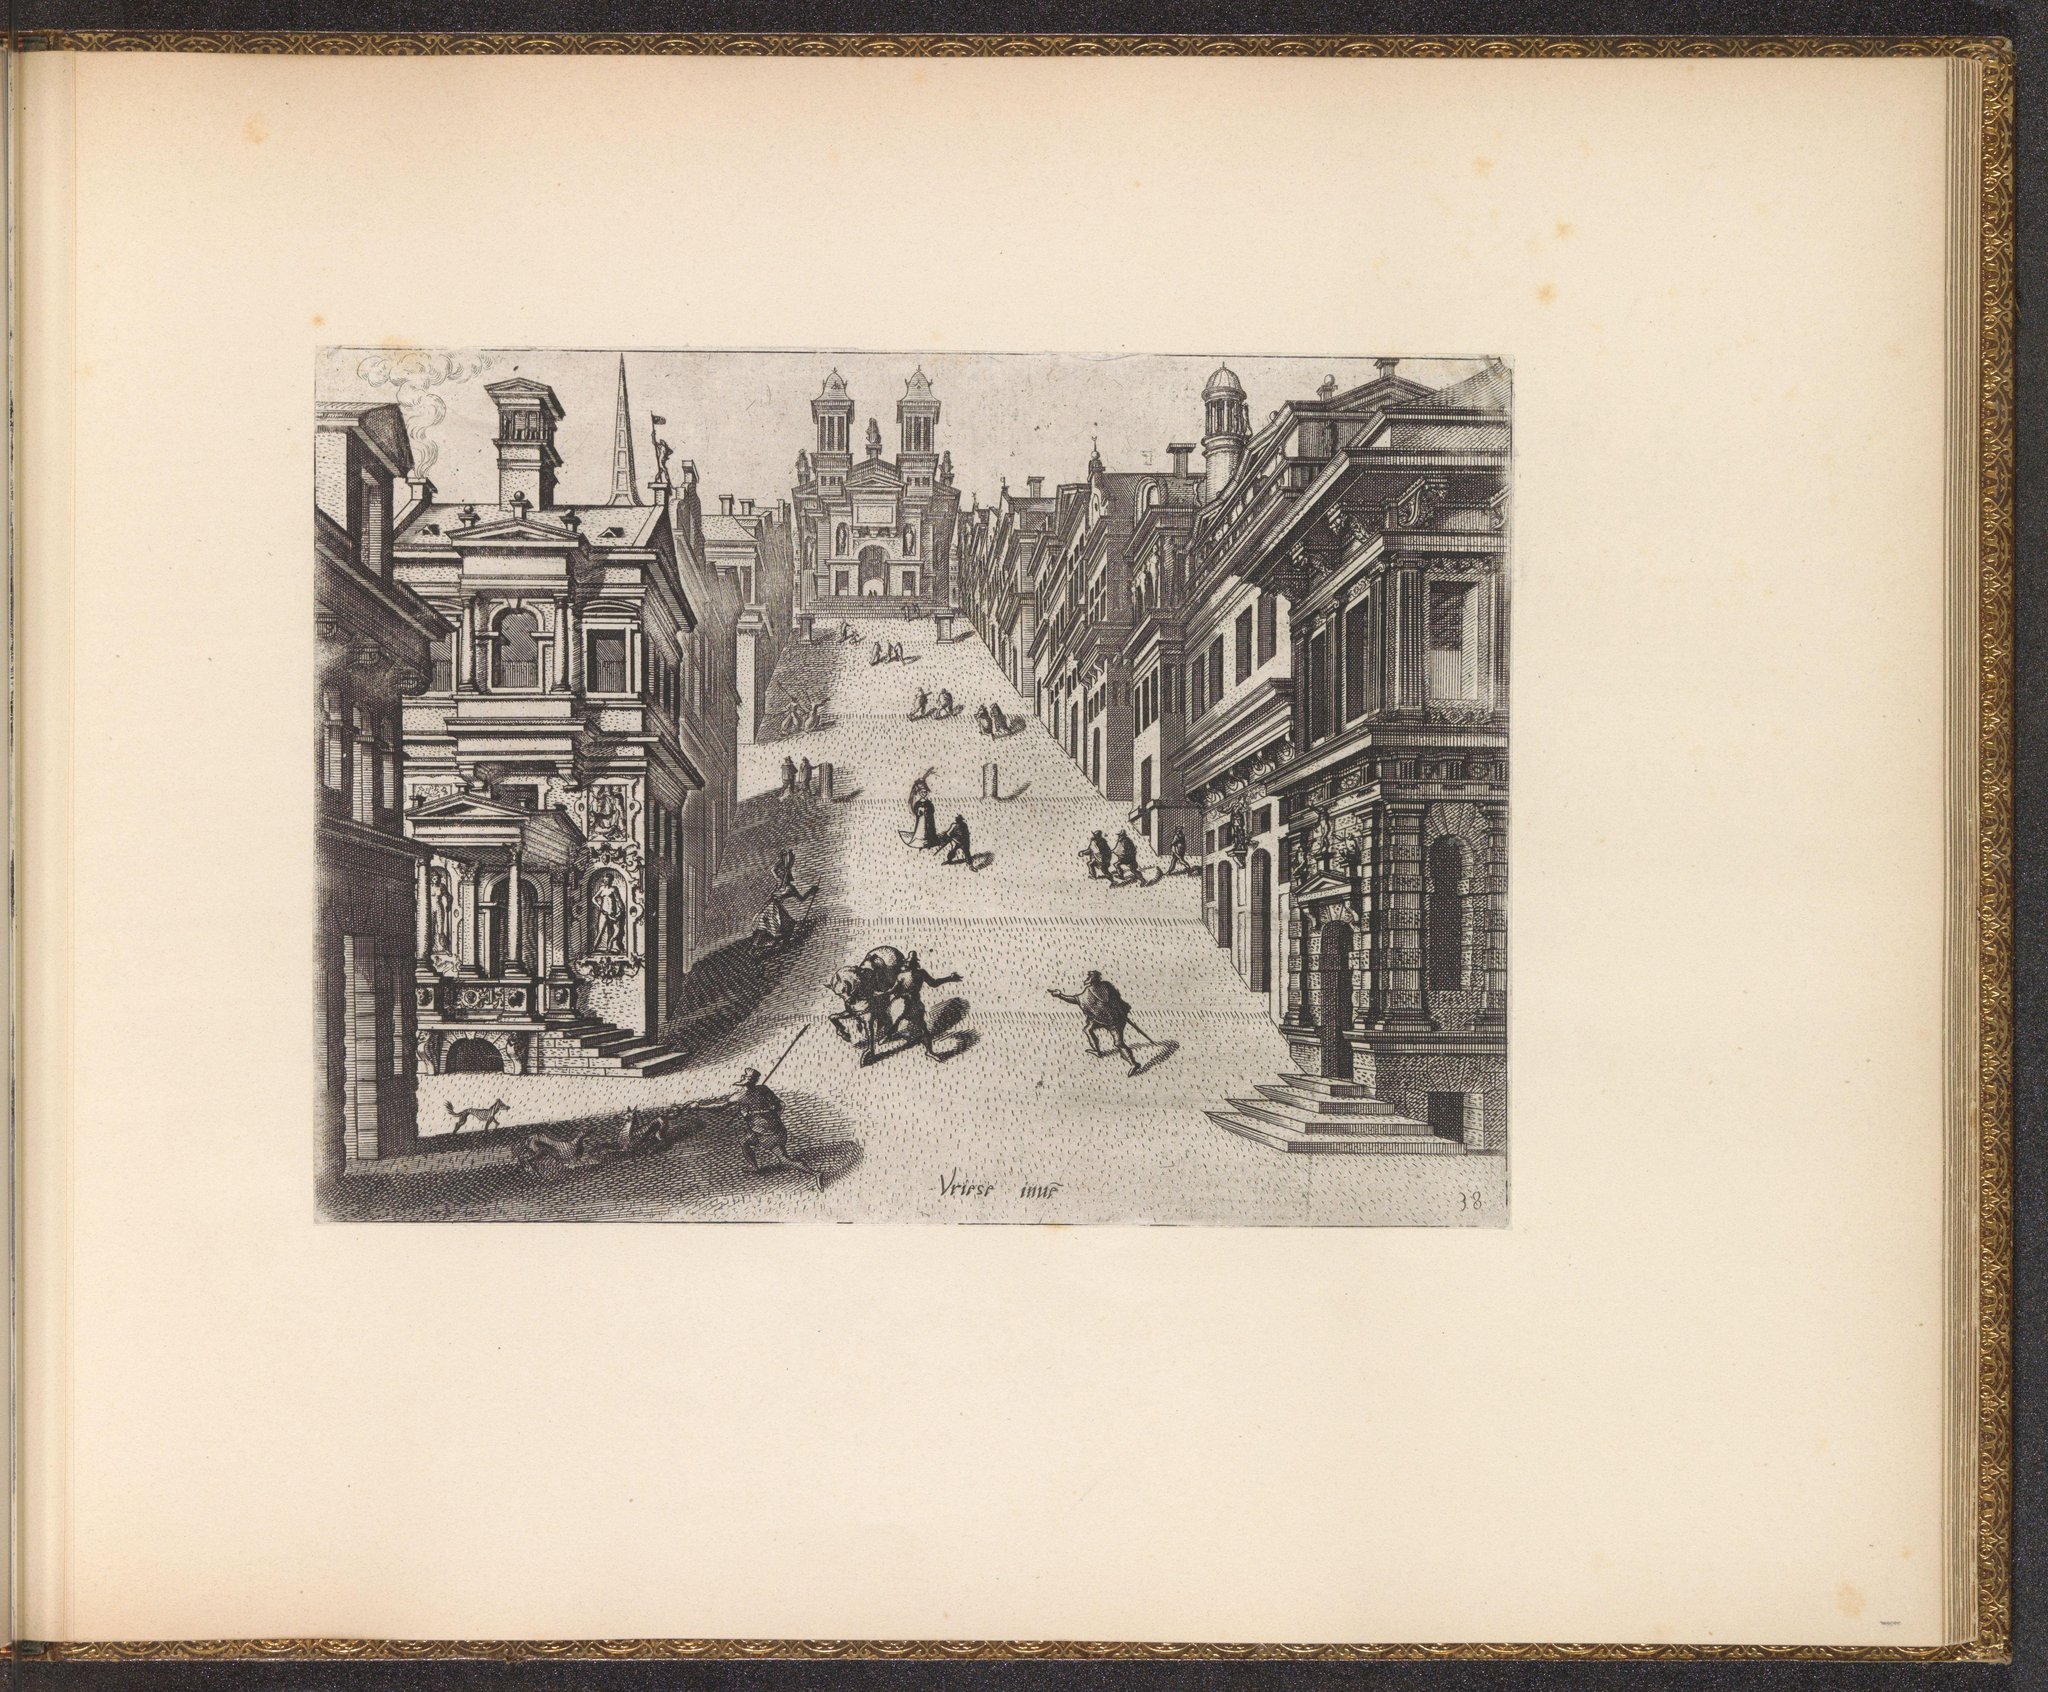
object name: ornament print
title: Architectuurperspectieven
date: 1601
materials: paper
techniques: etching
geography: antwerp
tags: city-view in general; 'veduta', gate, entrance, street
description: Oplopende brede straat met monumentale bebouwing. Aan het einde van de straat ligt een poortgebouw met twee torens. De prent maakt deel uit van een album.